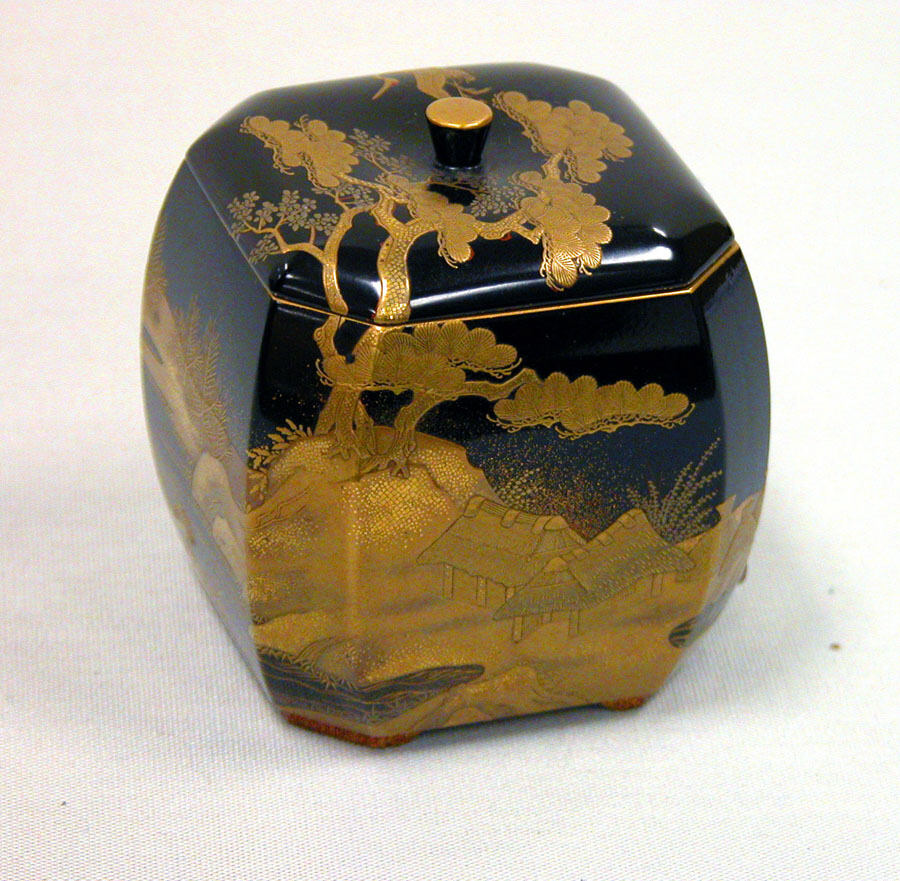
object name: tea jar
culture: japanese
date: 1701-1800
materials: gold, lacquer, metal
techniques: kirikane, maki-e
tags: cranes,trees